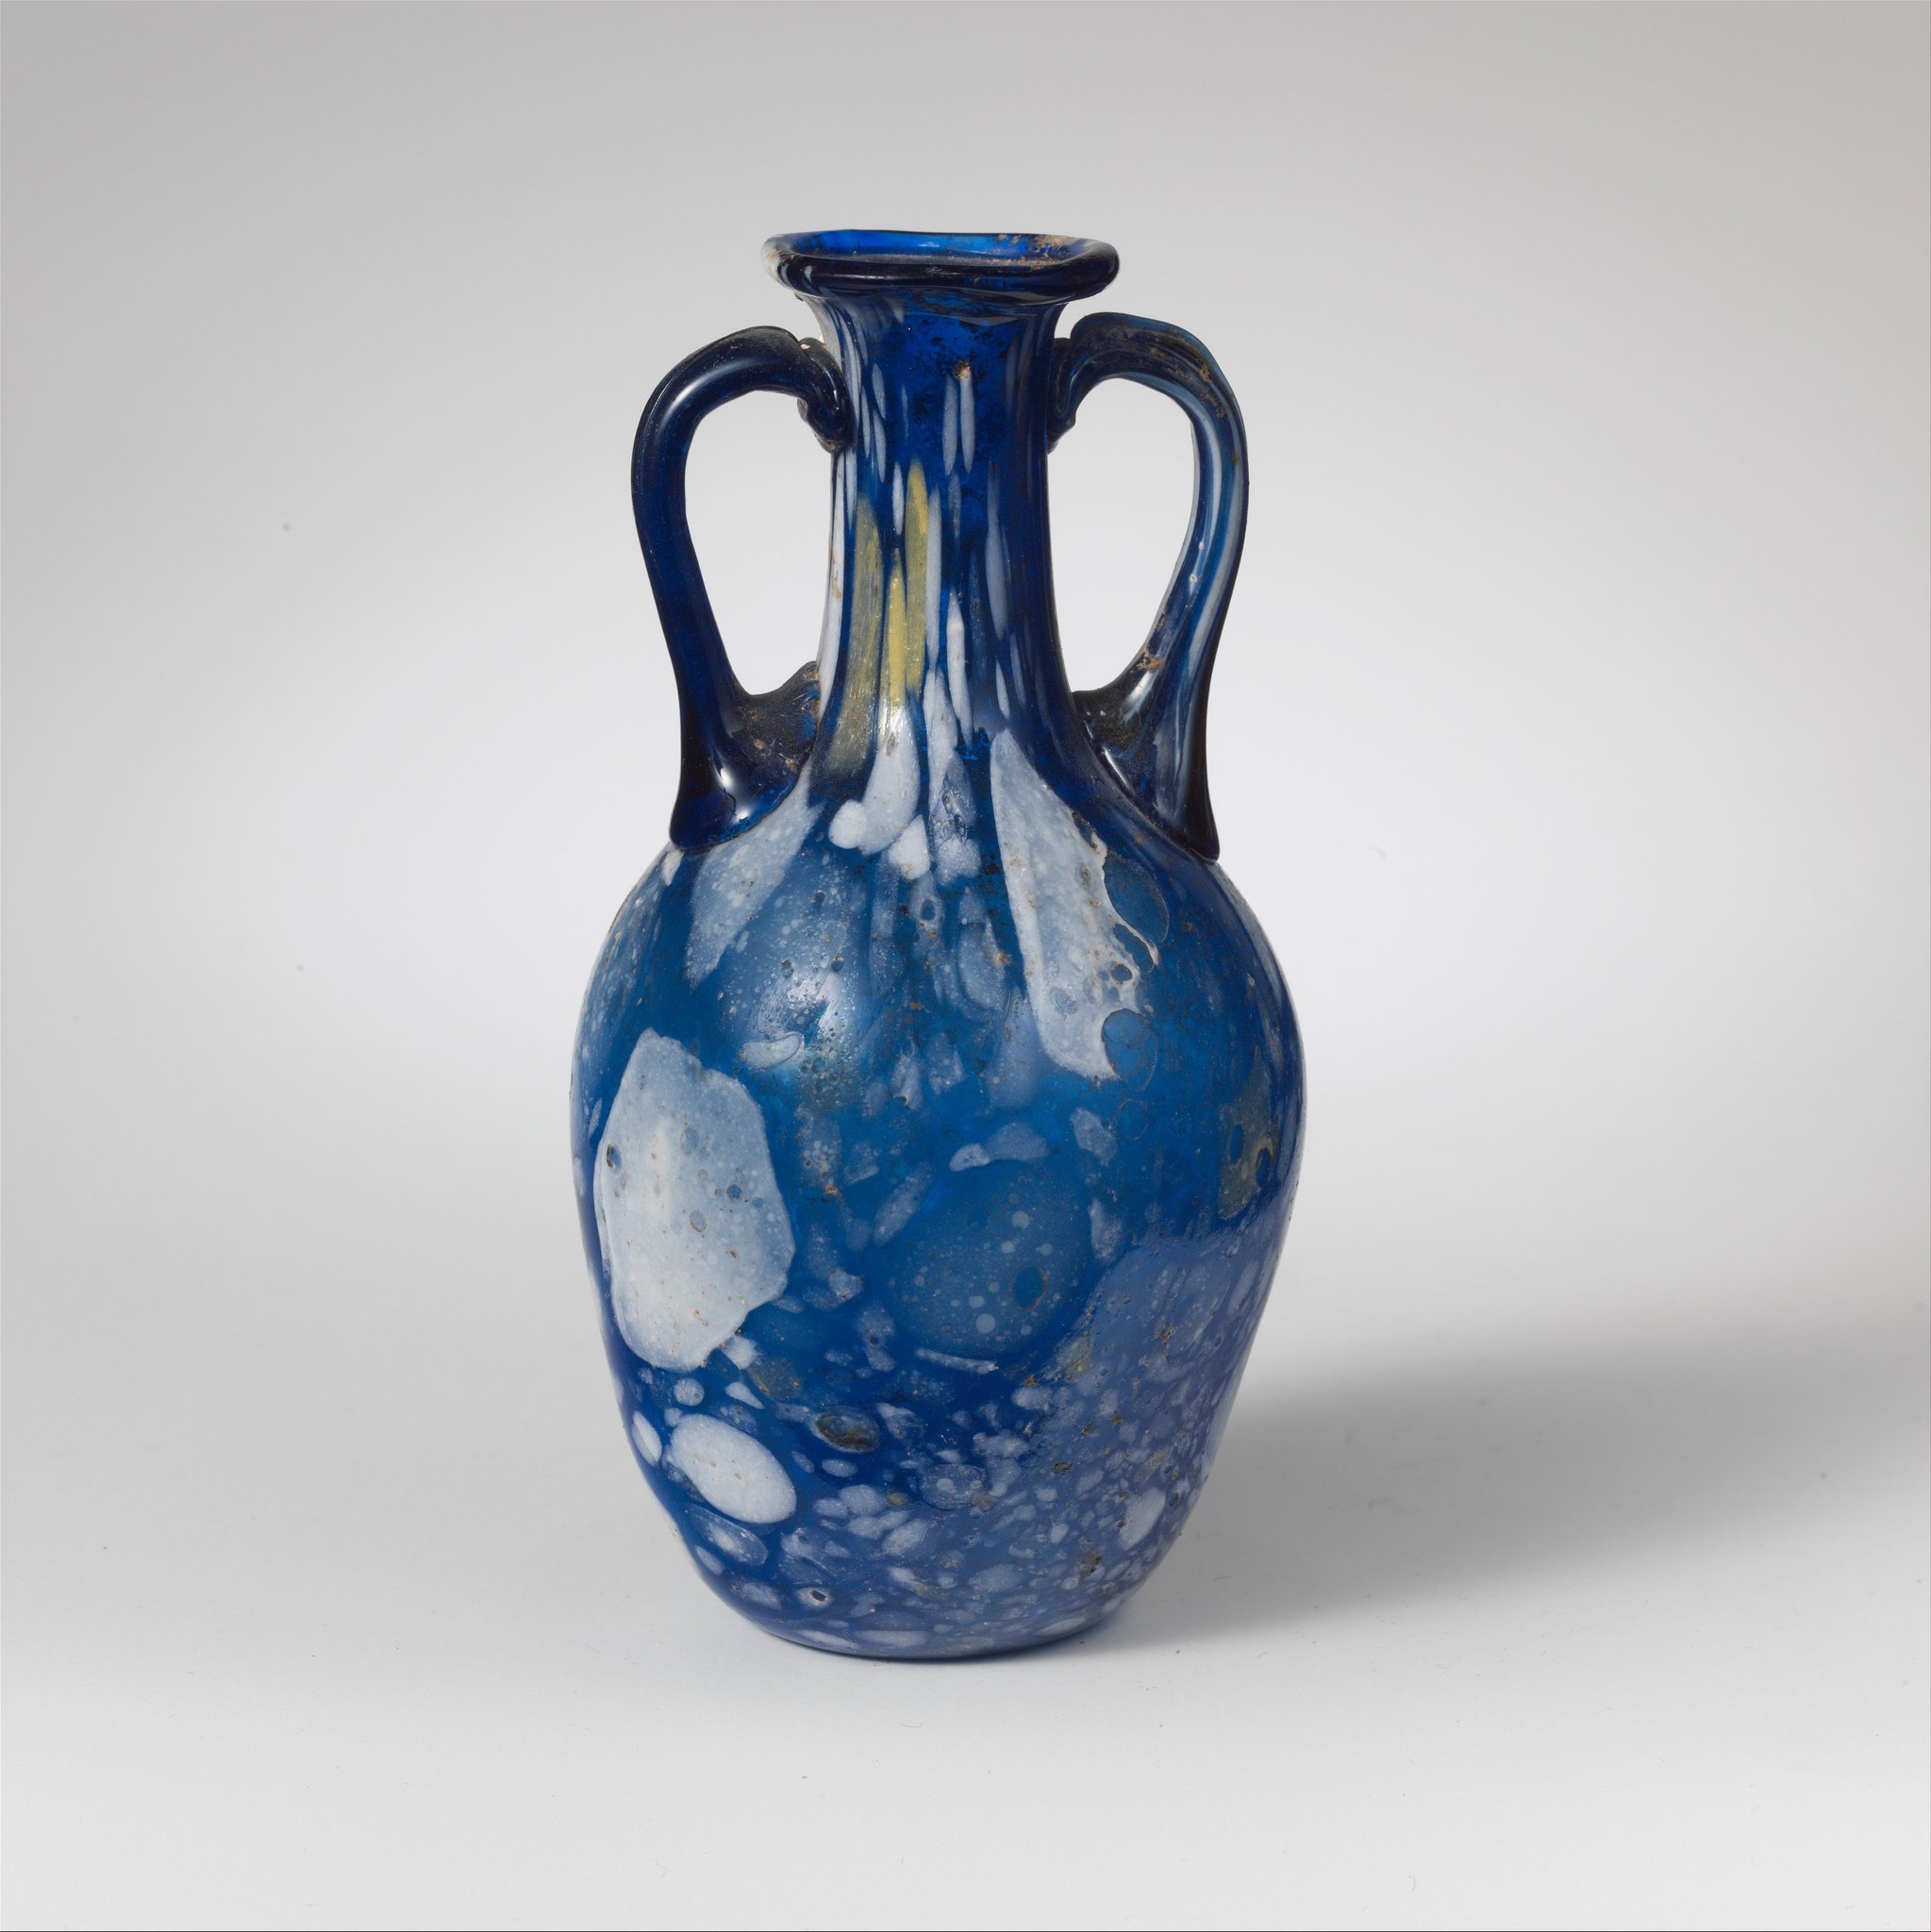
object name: bottle, two handled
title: Glass two-handled bottle (amphora)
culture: roman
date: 1-100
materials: glass